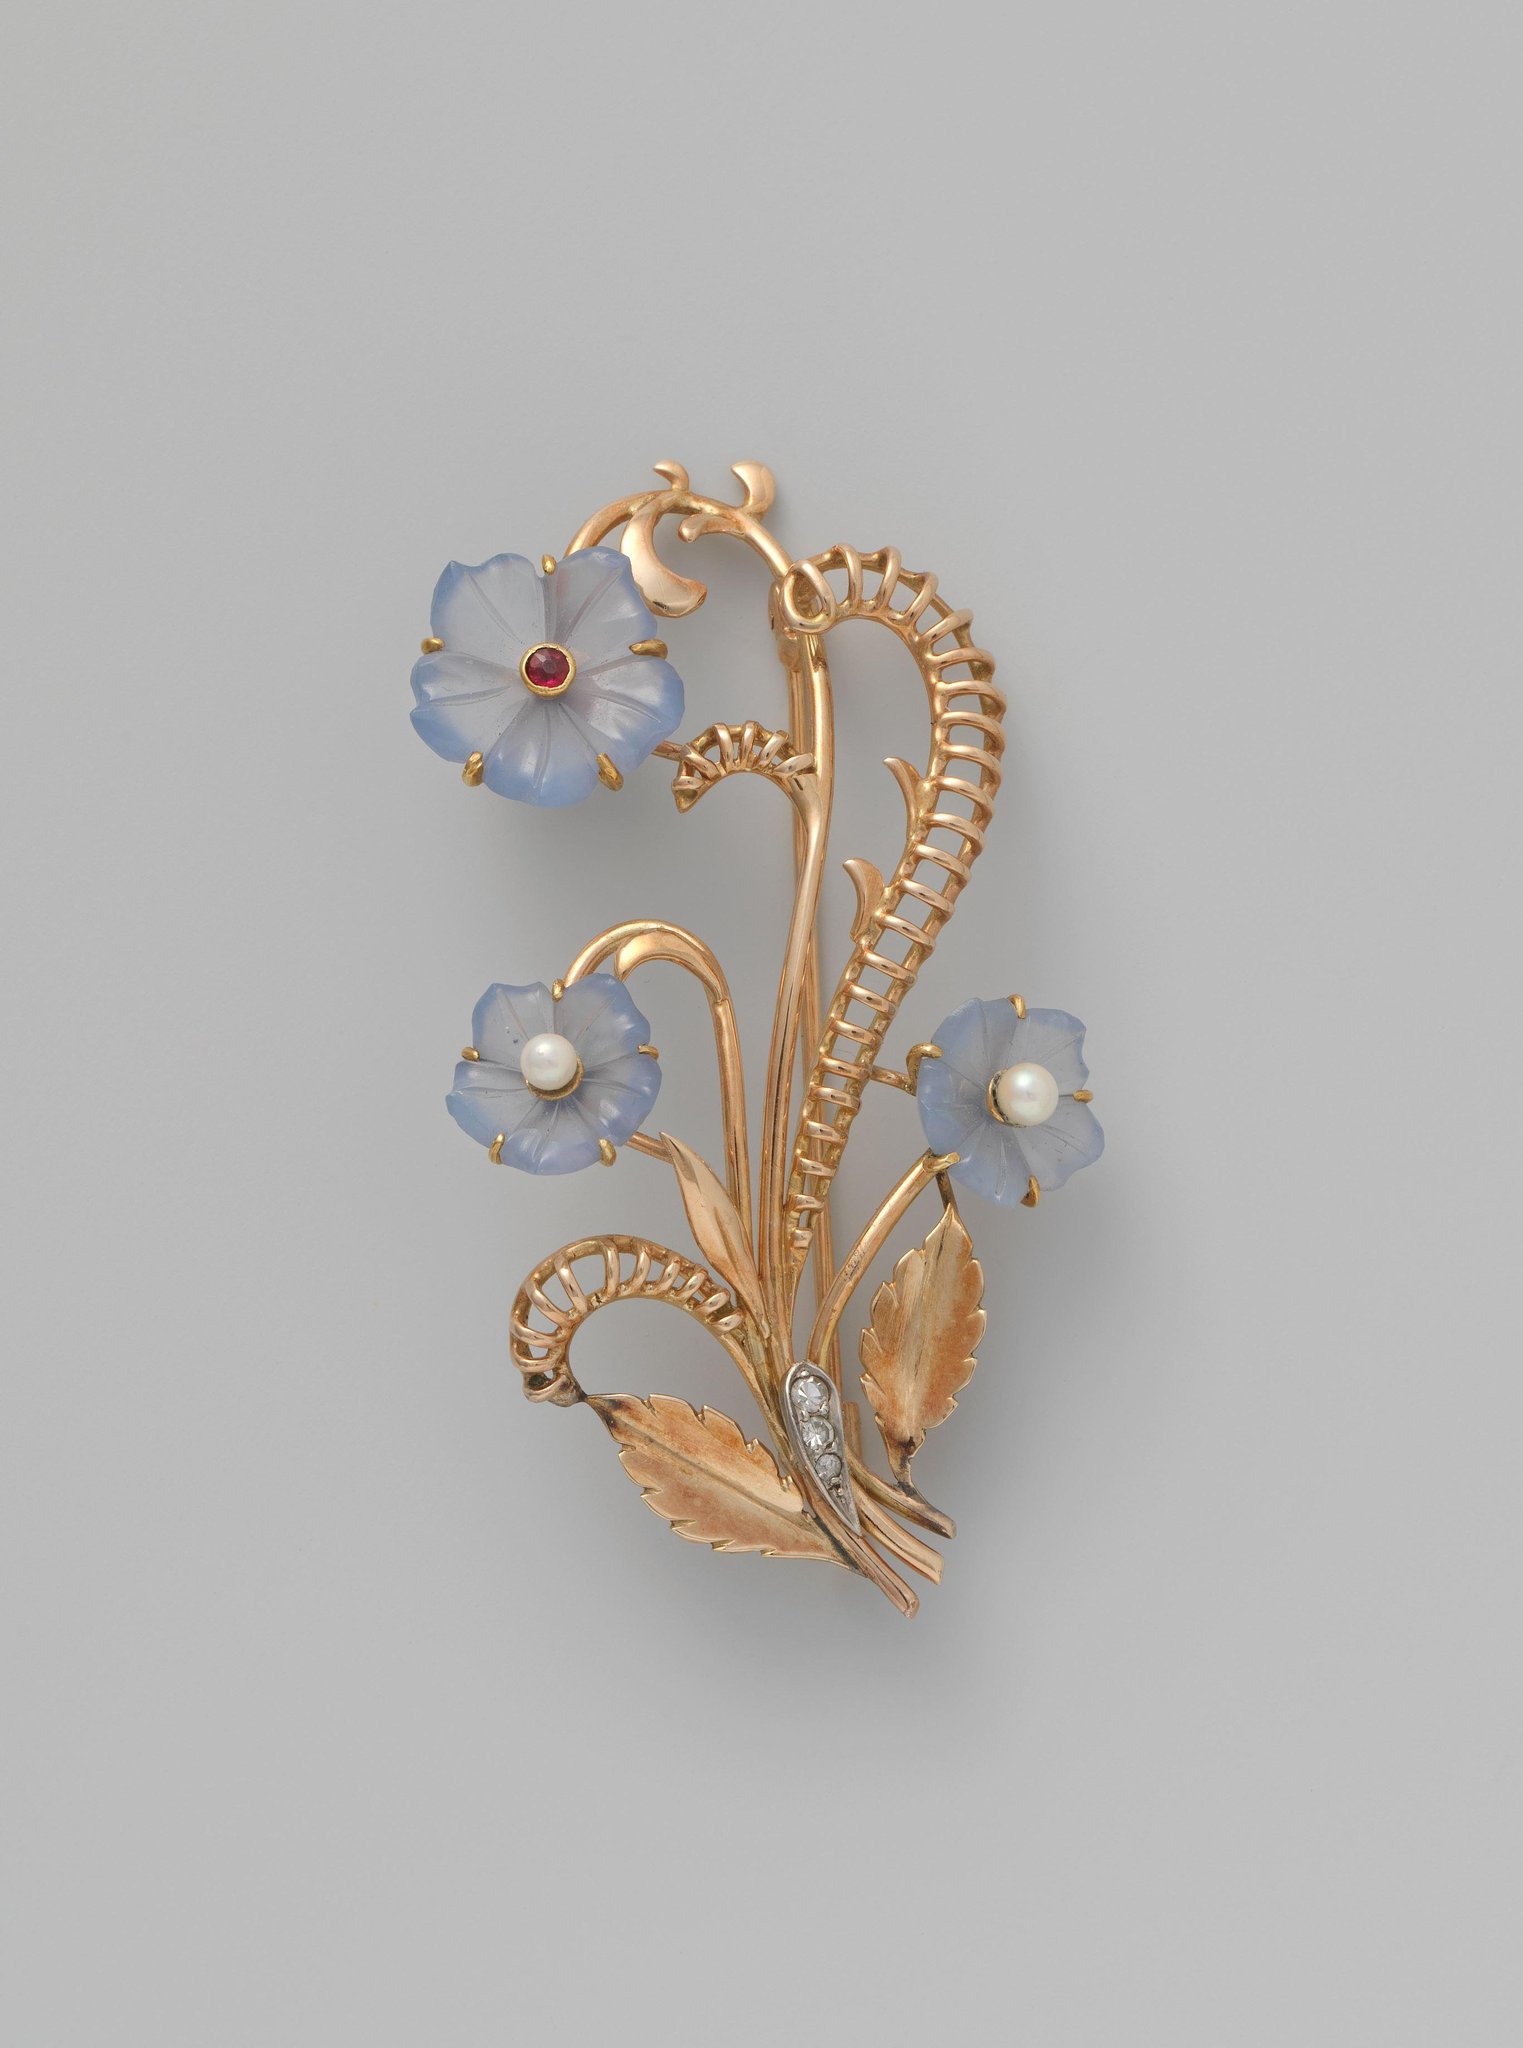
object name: brooch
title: Flower Brooche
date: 1945-1953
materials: stone, diamond, gold, pearl, gemstone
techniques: faceting, grinding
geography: the hague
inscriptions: alloy mark: ‘(oud) eikenblad’, maker's mark: ‘V.Z.K.’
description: Broche van roodgoud met drie bloemen van blauwe chalcedoon. De bovenste bloem heeft als hart een rondgefacetteerde robijn, de bloemen daaronder hebben elk één parel. Aan het ondereind van de stelen zitten direct boven elkaar diamanten. De broche is voorzien van een kanonsluiting.